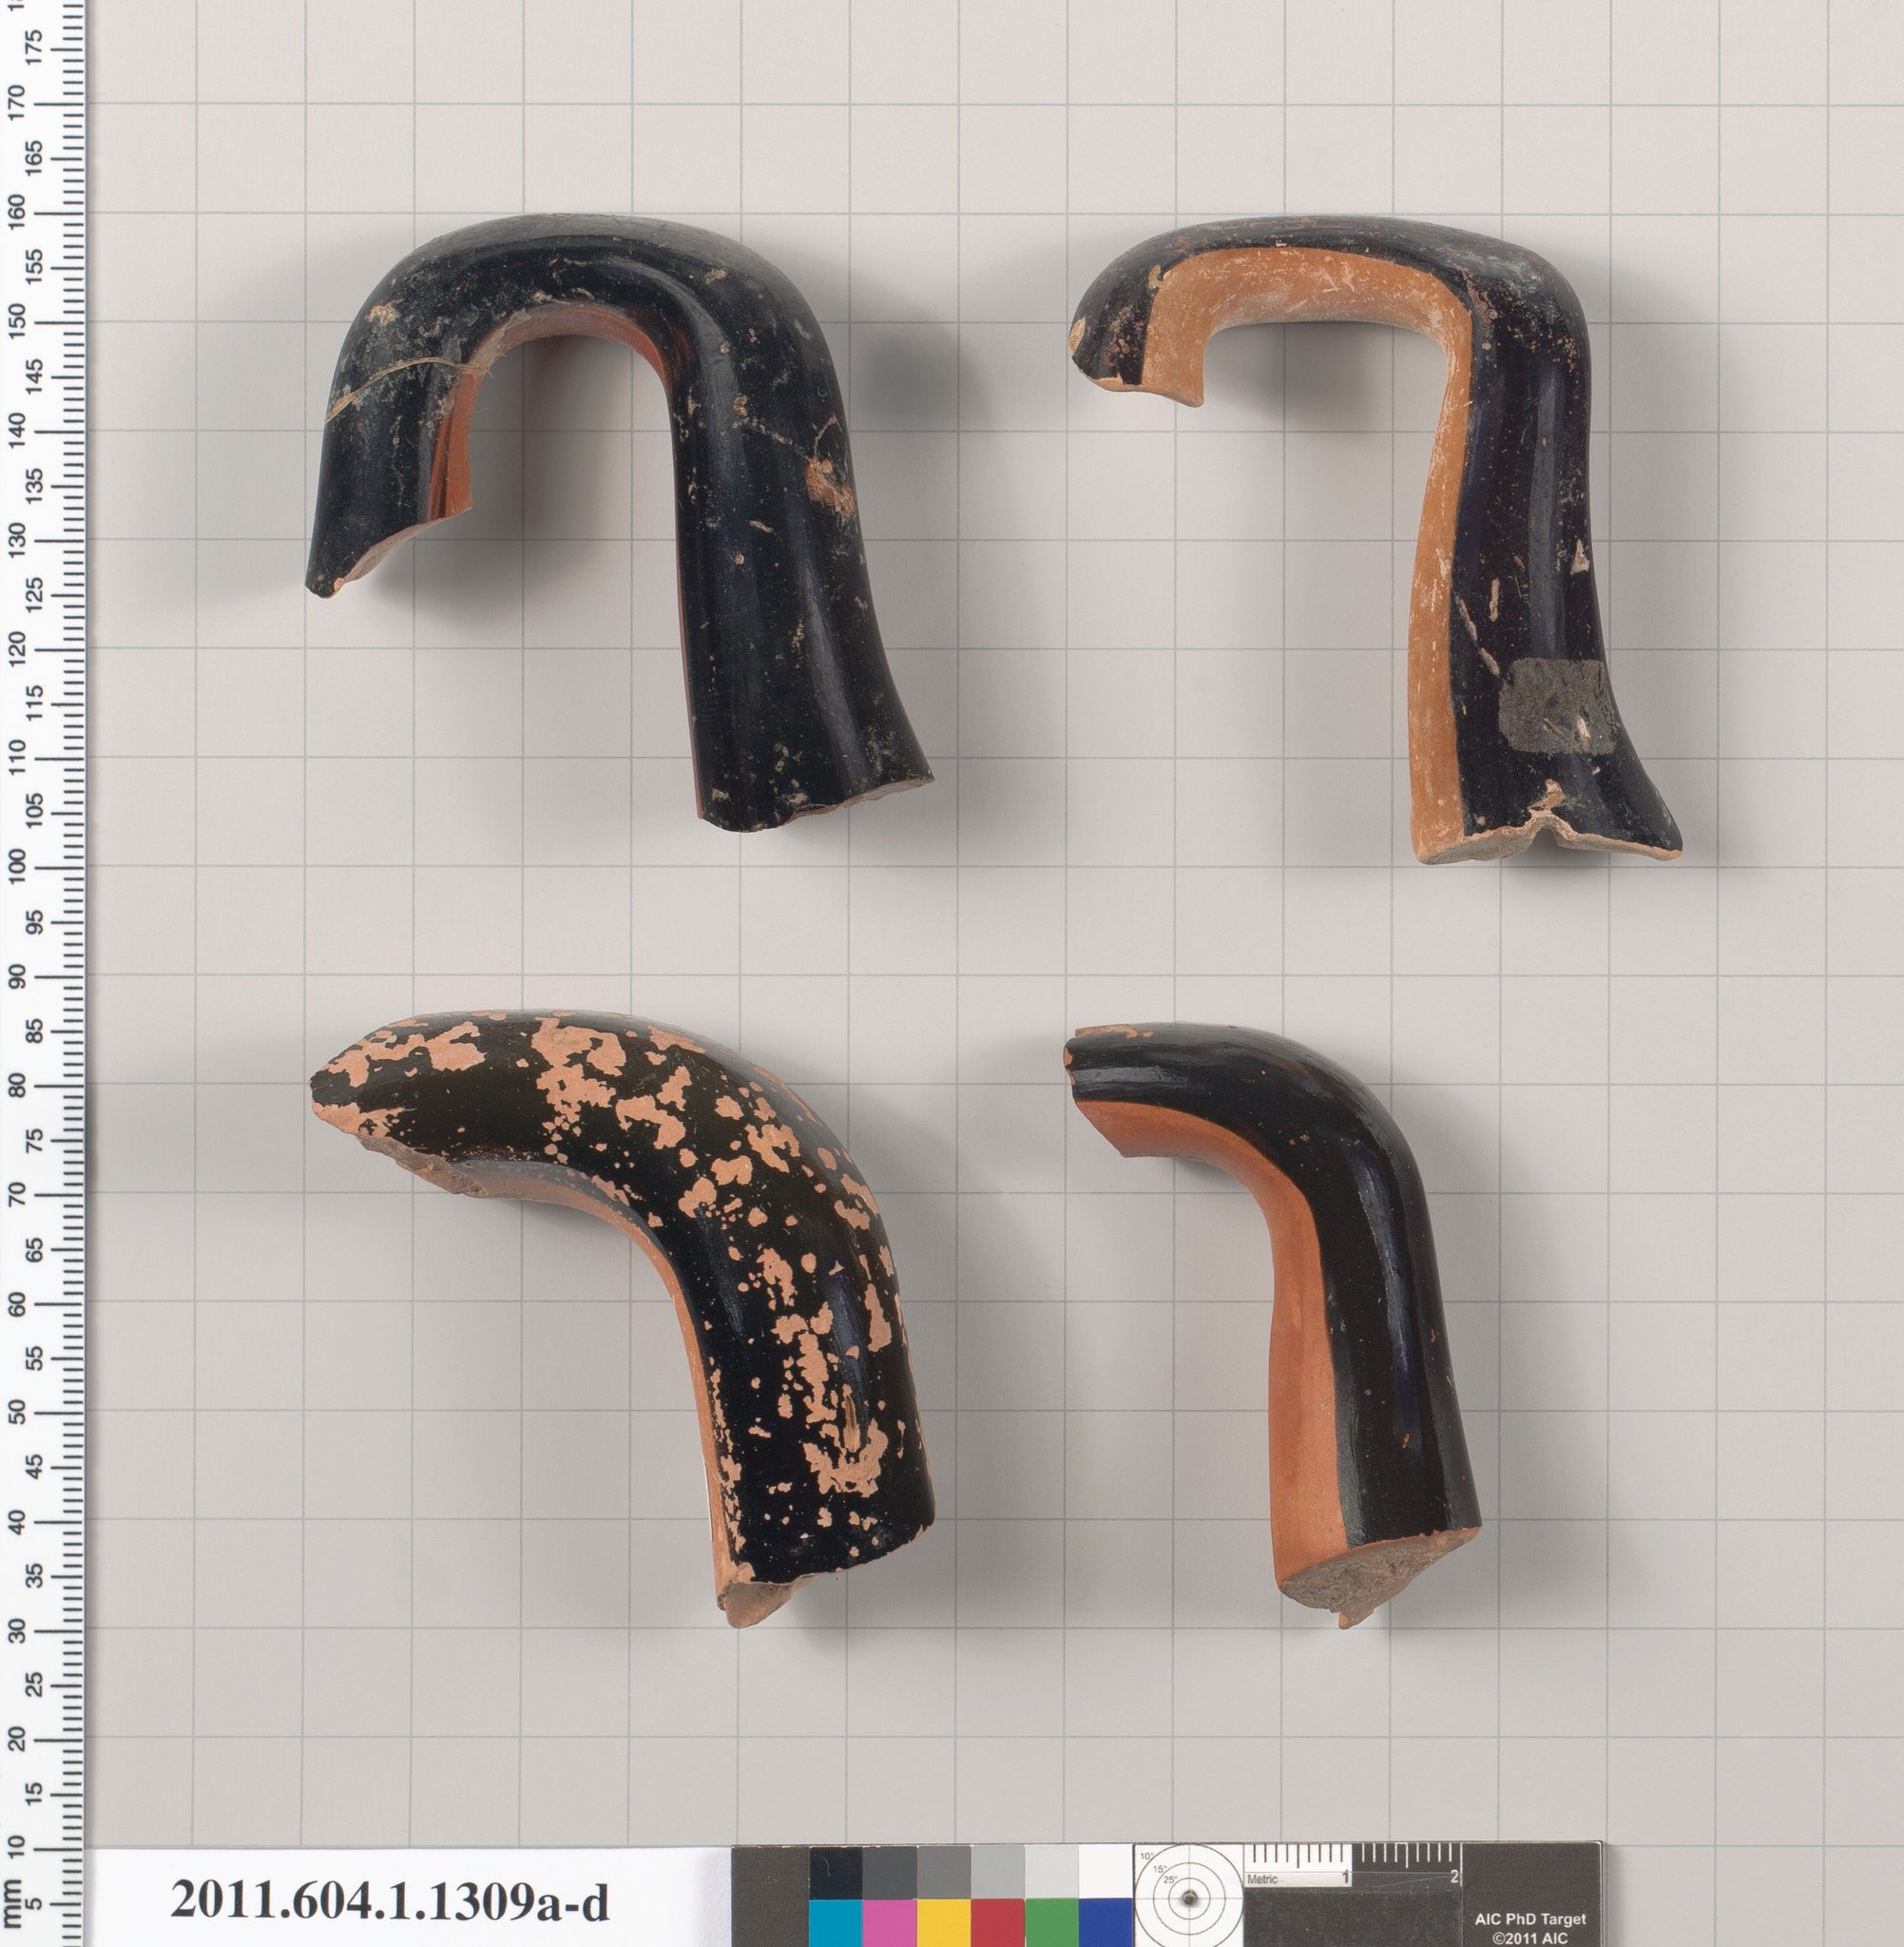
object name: kylix fragment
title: Terracotta fragments of kylikes (drinking cups)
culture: greek, attic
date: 500-401 BCE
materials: terracotta